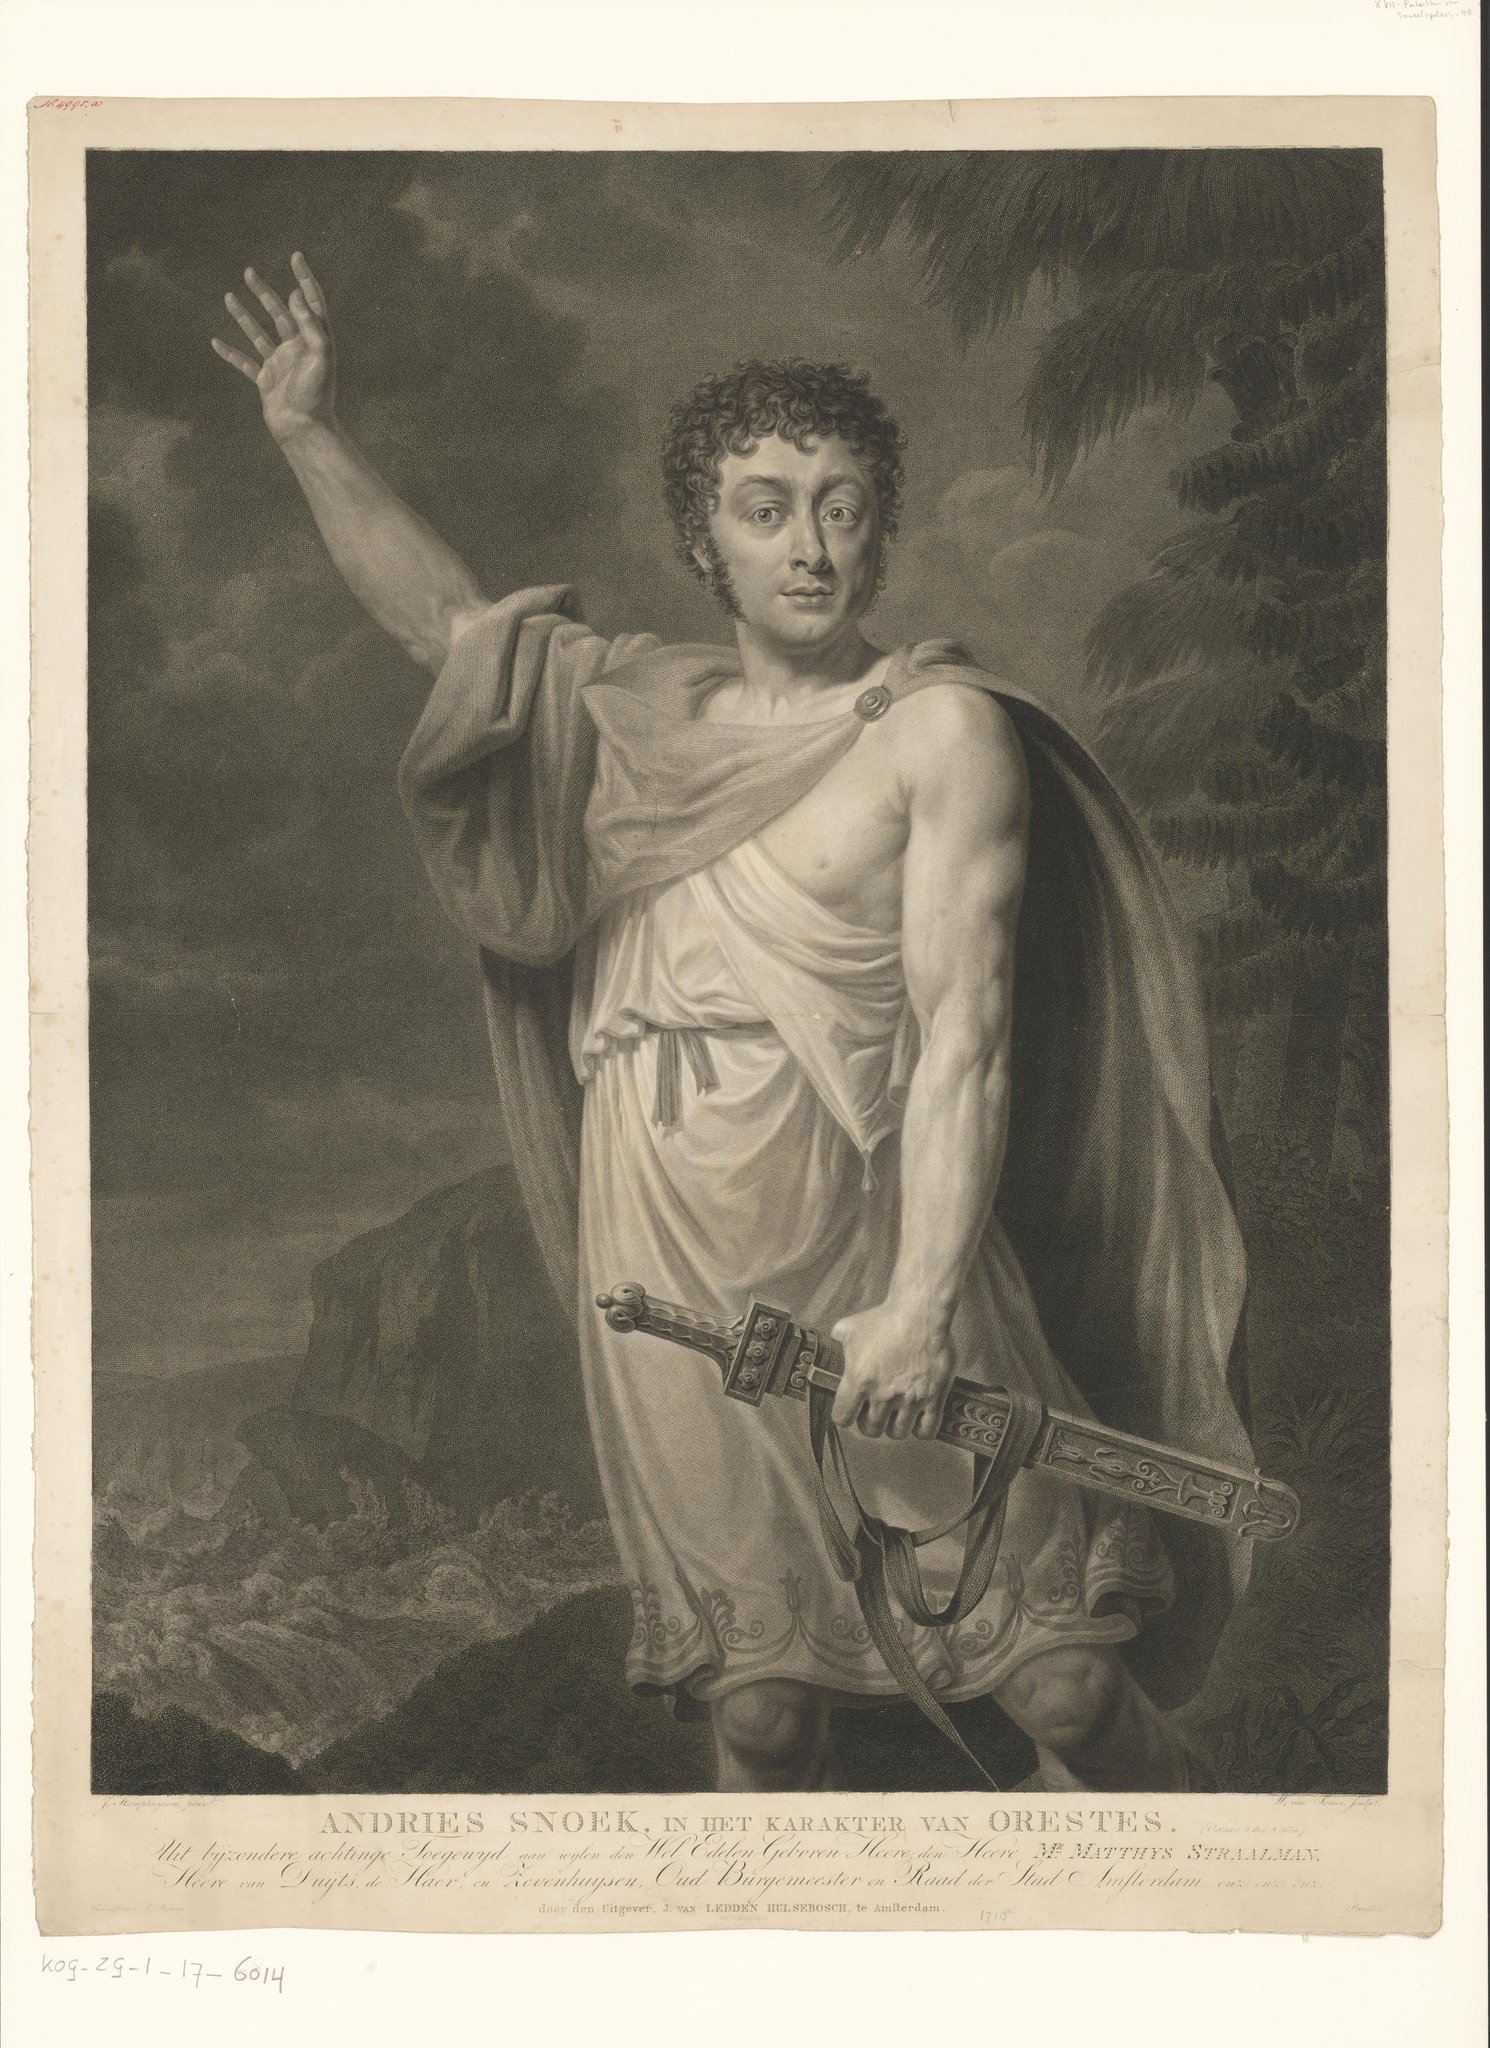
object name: print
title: Andries Snoek, in het karakter van Orestes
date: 1802-1808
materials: paper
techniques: stippled etching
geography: netherlands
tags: rotterdam, amsterdam, historical persons, portrait of actor, actress, actor (on the stage)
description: Portret van de toneelspeler Andreas Snoek in de rol van Orestes. Hij draagt een kort zwaard in de hand en is afgebeeld tegen de achtergrond van een woeste zee met hoge kliffen. Onderwerpsrubrieken binnen de Atlas Zeden en Gewoonten: Tooneel, Portretten van toneelspelers.